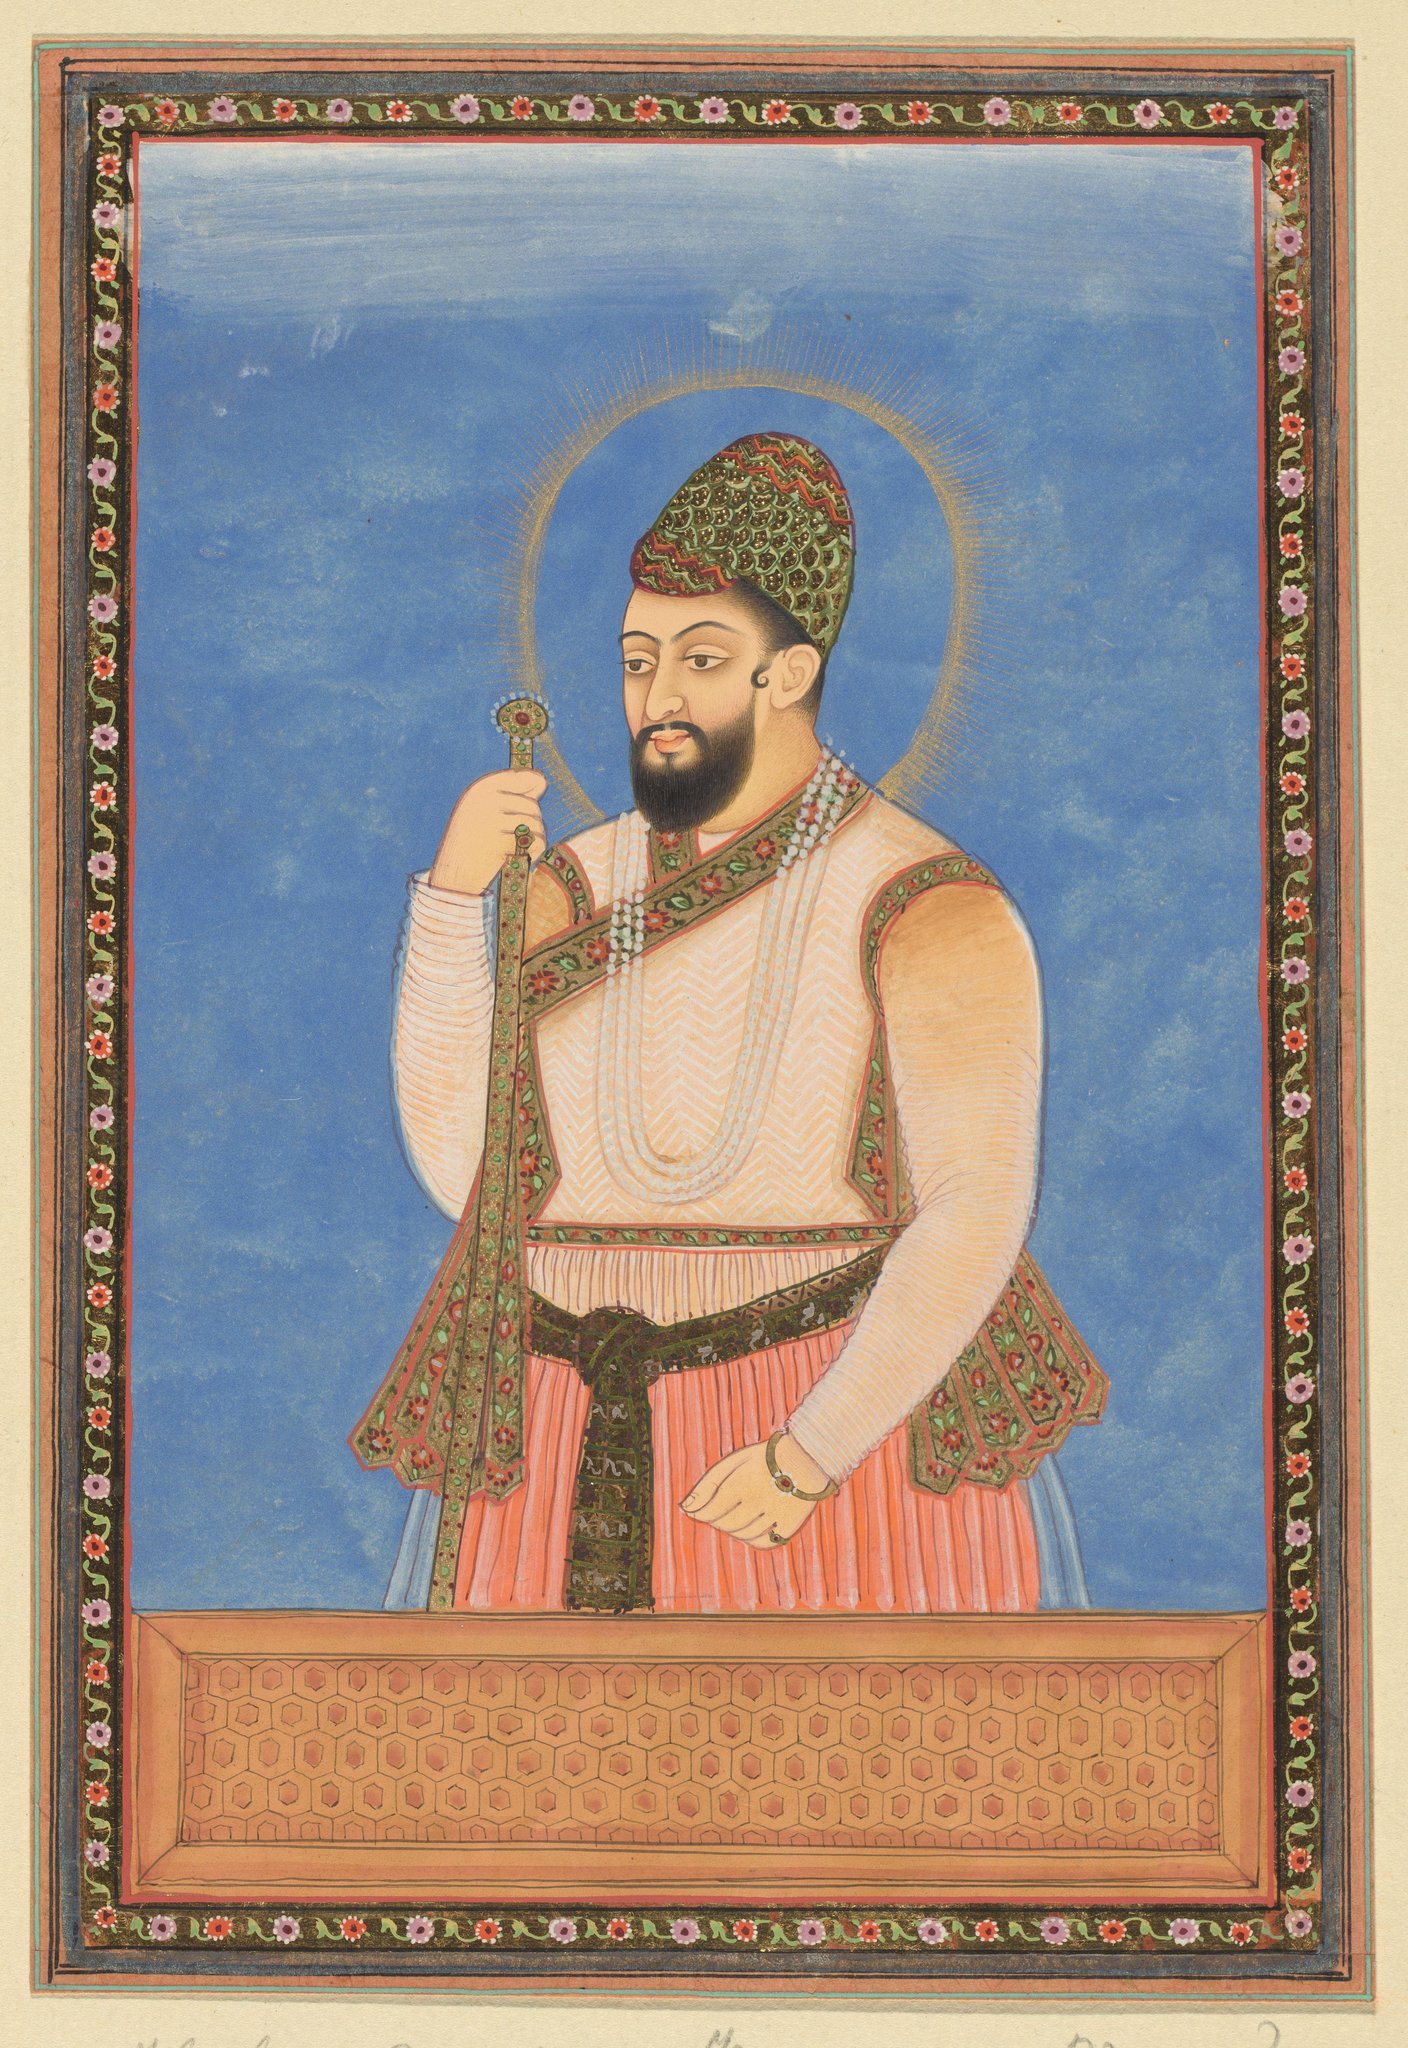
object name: indian miniature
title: Portret van Ibrahim Adil-shah, die de eerste heerser van Bijapur is geweest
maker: Anonymous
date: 1686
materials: paint, gold leaf, gouache, paper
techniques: brush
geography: golkonda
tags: amsterdam, print maker, nicolaes cornelisz. witsen, historical person (...) - historical person (...) portrayed alone, ruler, sovereign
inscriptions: collector's mark: Lugt 1838, collector's mark: Lugt 240, annotation: ‘Ibrahim Adilstah, Koning van Sugiapour of Vigiapour’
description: Ibrahim Adil-shah is tot aan zijn heupen afgebeeld, half naar links gewend, met in zijn rechter hand een staf. Blad 39 in het `Witsen-Album', met 49 Indiase miniaturen van vorsten. Boven het portret een stukje papier met de naam in het Perzisch. Onder het portret een stukje papier met de naam in het Portugees.